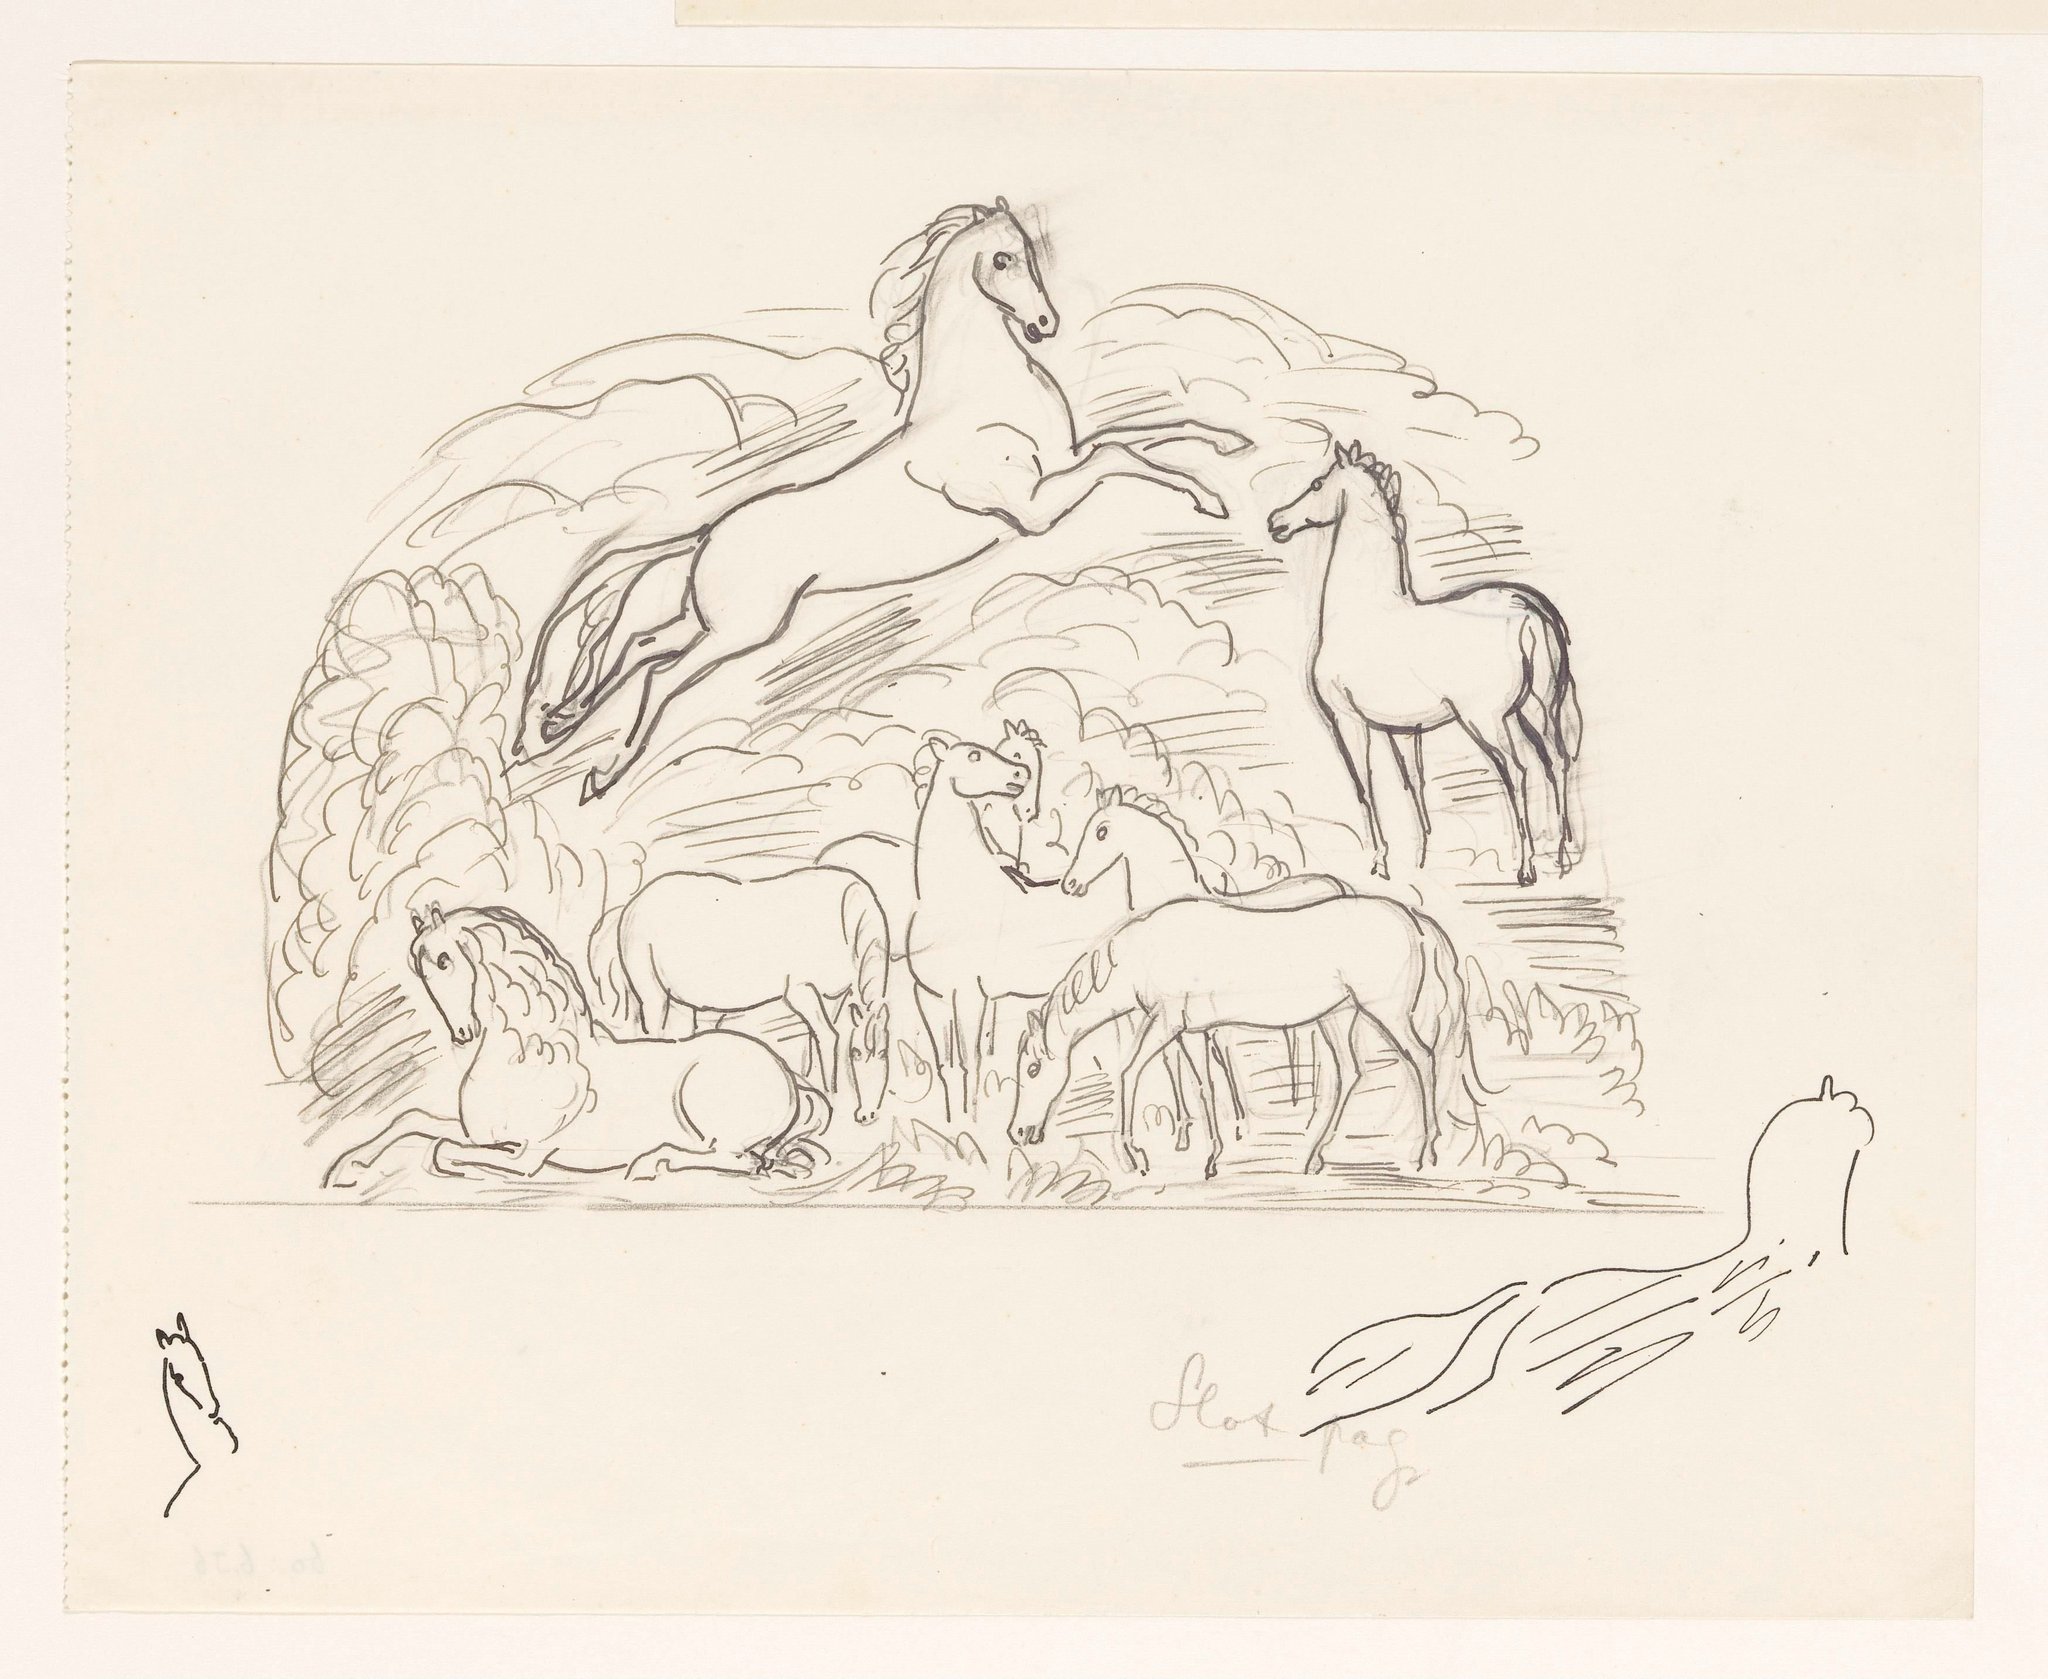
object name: drawing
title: Studieblad met acht paarden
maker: leo gestel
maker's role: draughtsman, print maker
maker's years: 1881-1941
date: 1891-1941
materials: ink, paper, pencil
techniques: pen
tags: horse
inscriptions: watermark: ‘GW/ PAPIER/ 1671’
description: Onderin nog twee losse studies van paarden.